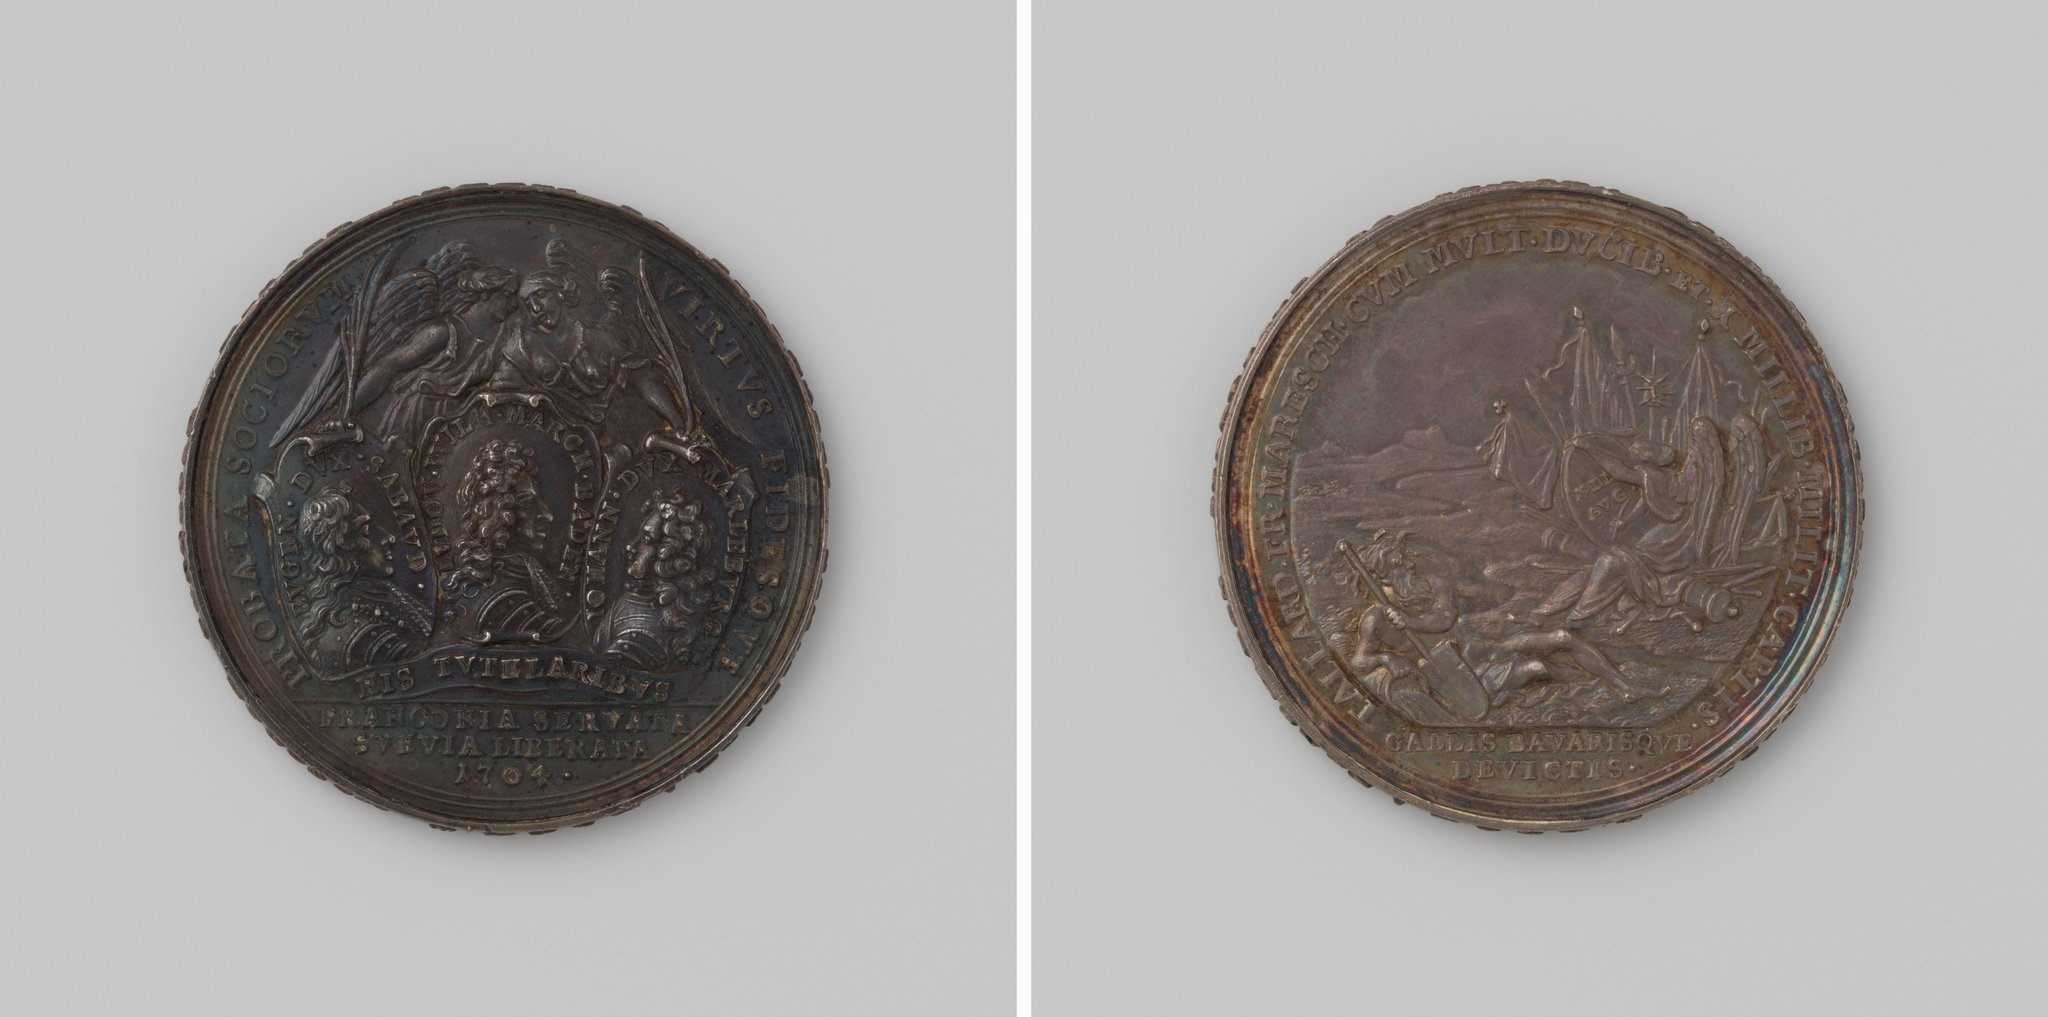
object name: history medal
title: Slag bij Blenheim, ter ere van Eugenius, hertog van Savoye, Lodewijk Willem, markgraaf van Baden en de hertog van Marlborough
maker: friedrich kleinert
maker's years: 1633-1714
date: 1704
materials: silver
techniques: striking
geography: nuremberg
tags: paris, vienna, eugenius van savoye, john churchill (1e hertog van marlborough)